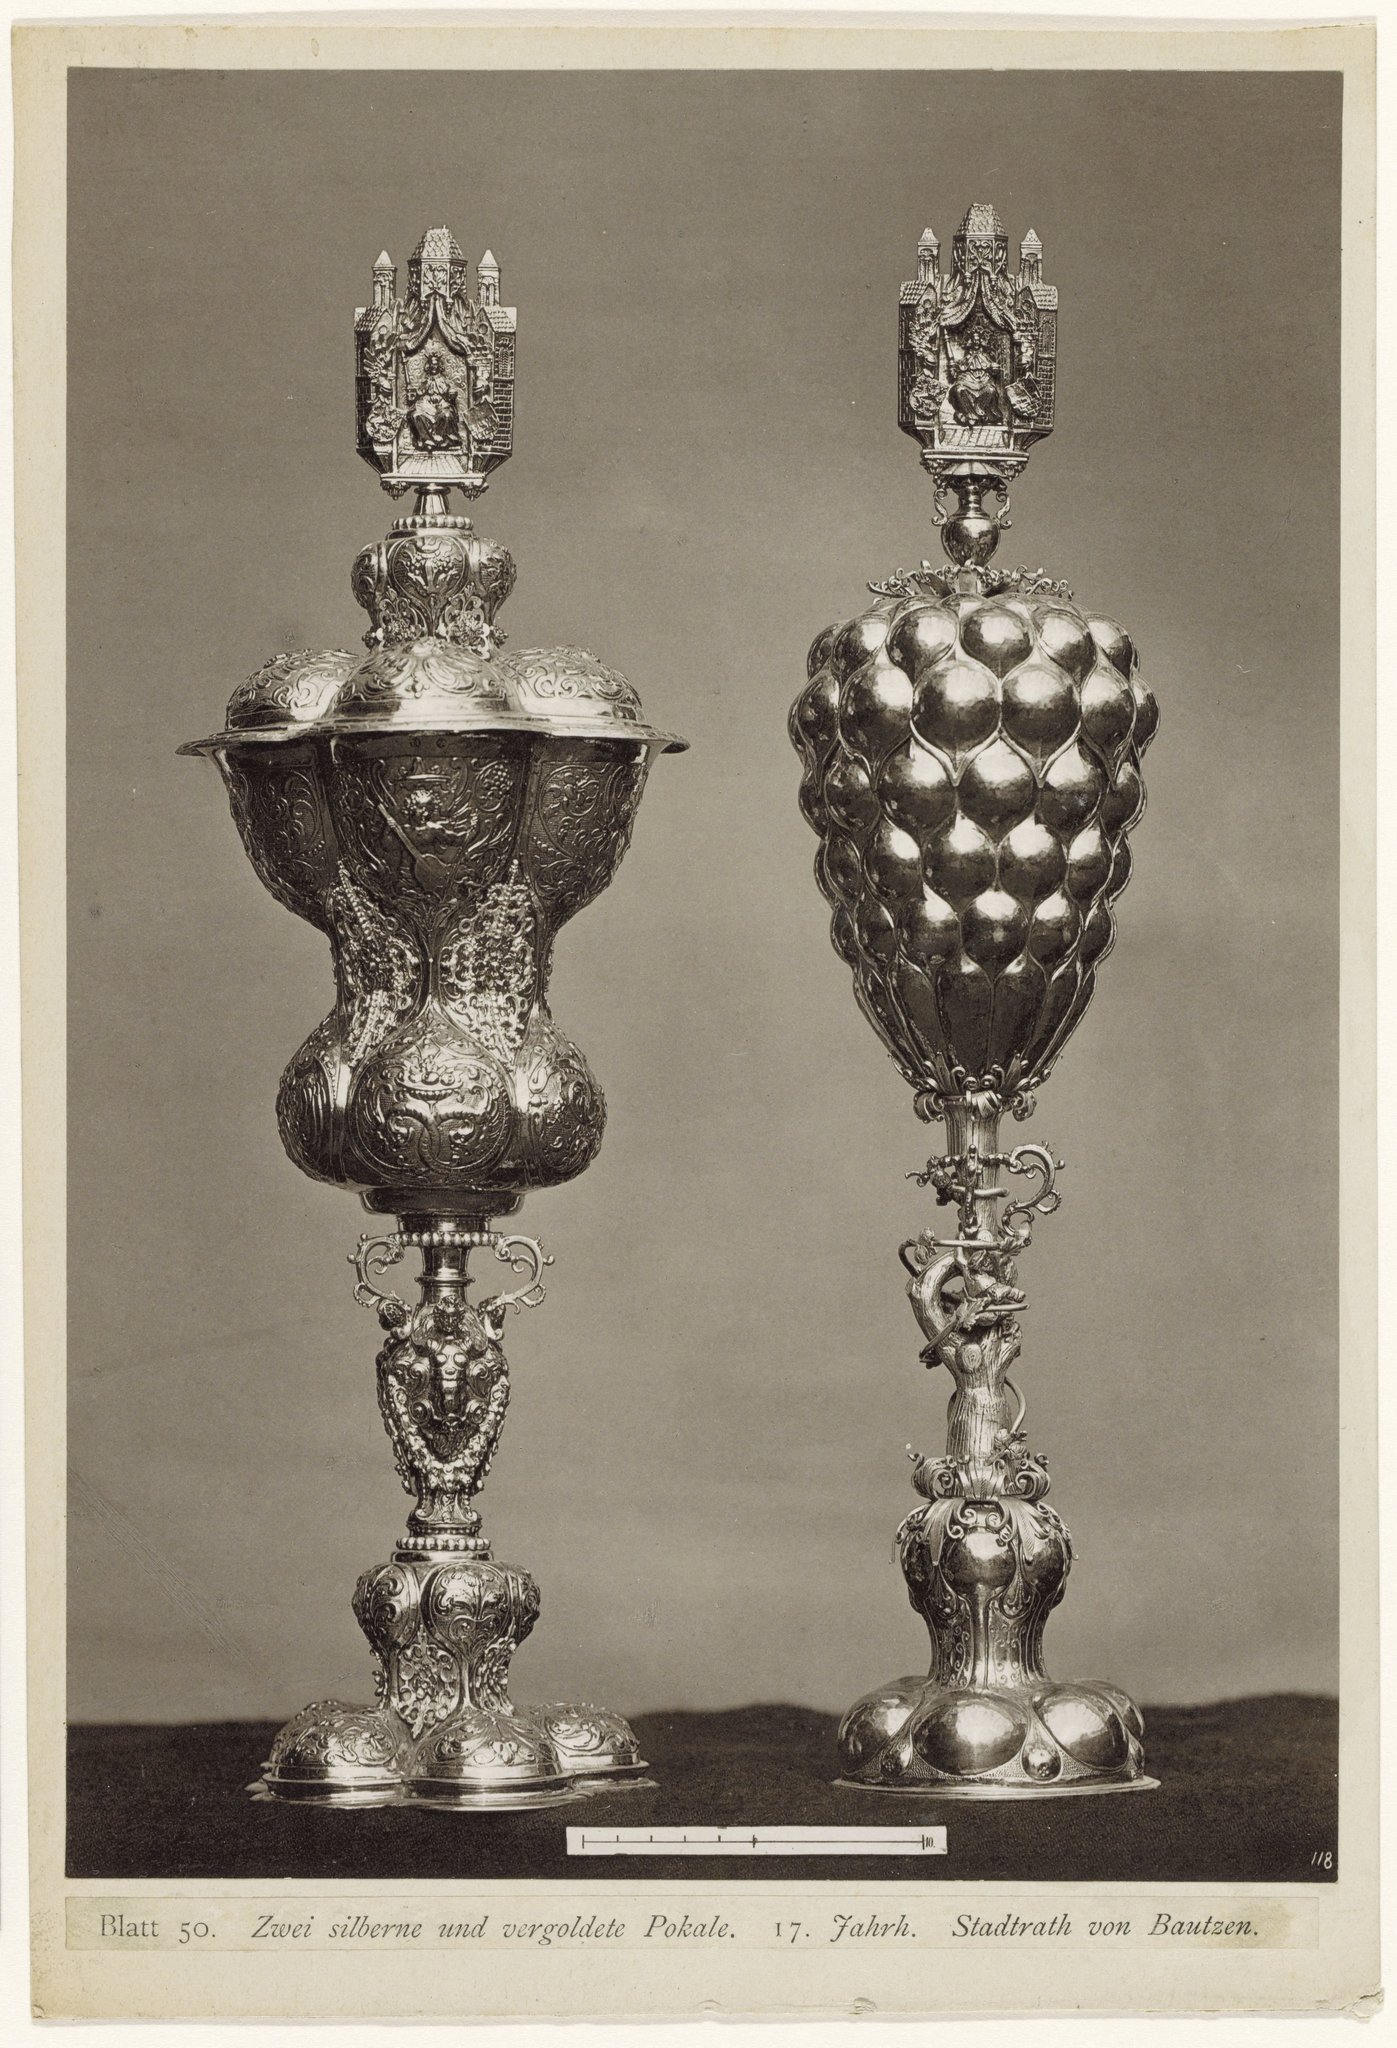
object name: photomechanical print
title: Twee zilveren en vergulde bokalen uit de zeventiende eeuw, Bautzen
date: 1869-1887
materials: cardboard, paper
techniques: photograph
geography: munich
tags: mug, beaker, goblet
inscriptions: title: ‘Blatt 50. Zwei silberne und vergoldete Pokale. 17. Jahrh. Stadrath von Bautzen.’, number: ‘118’